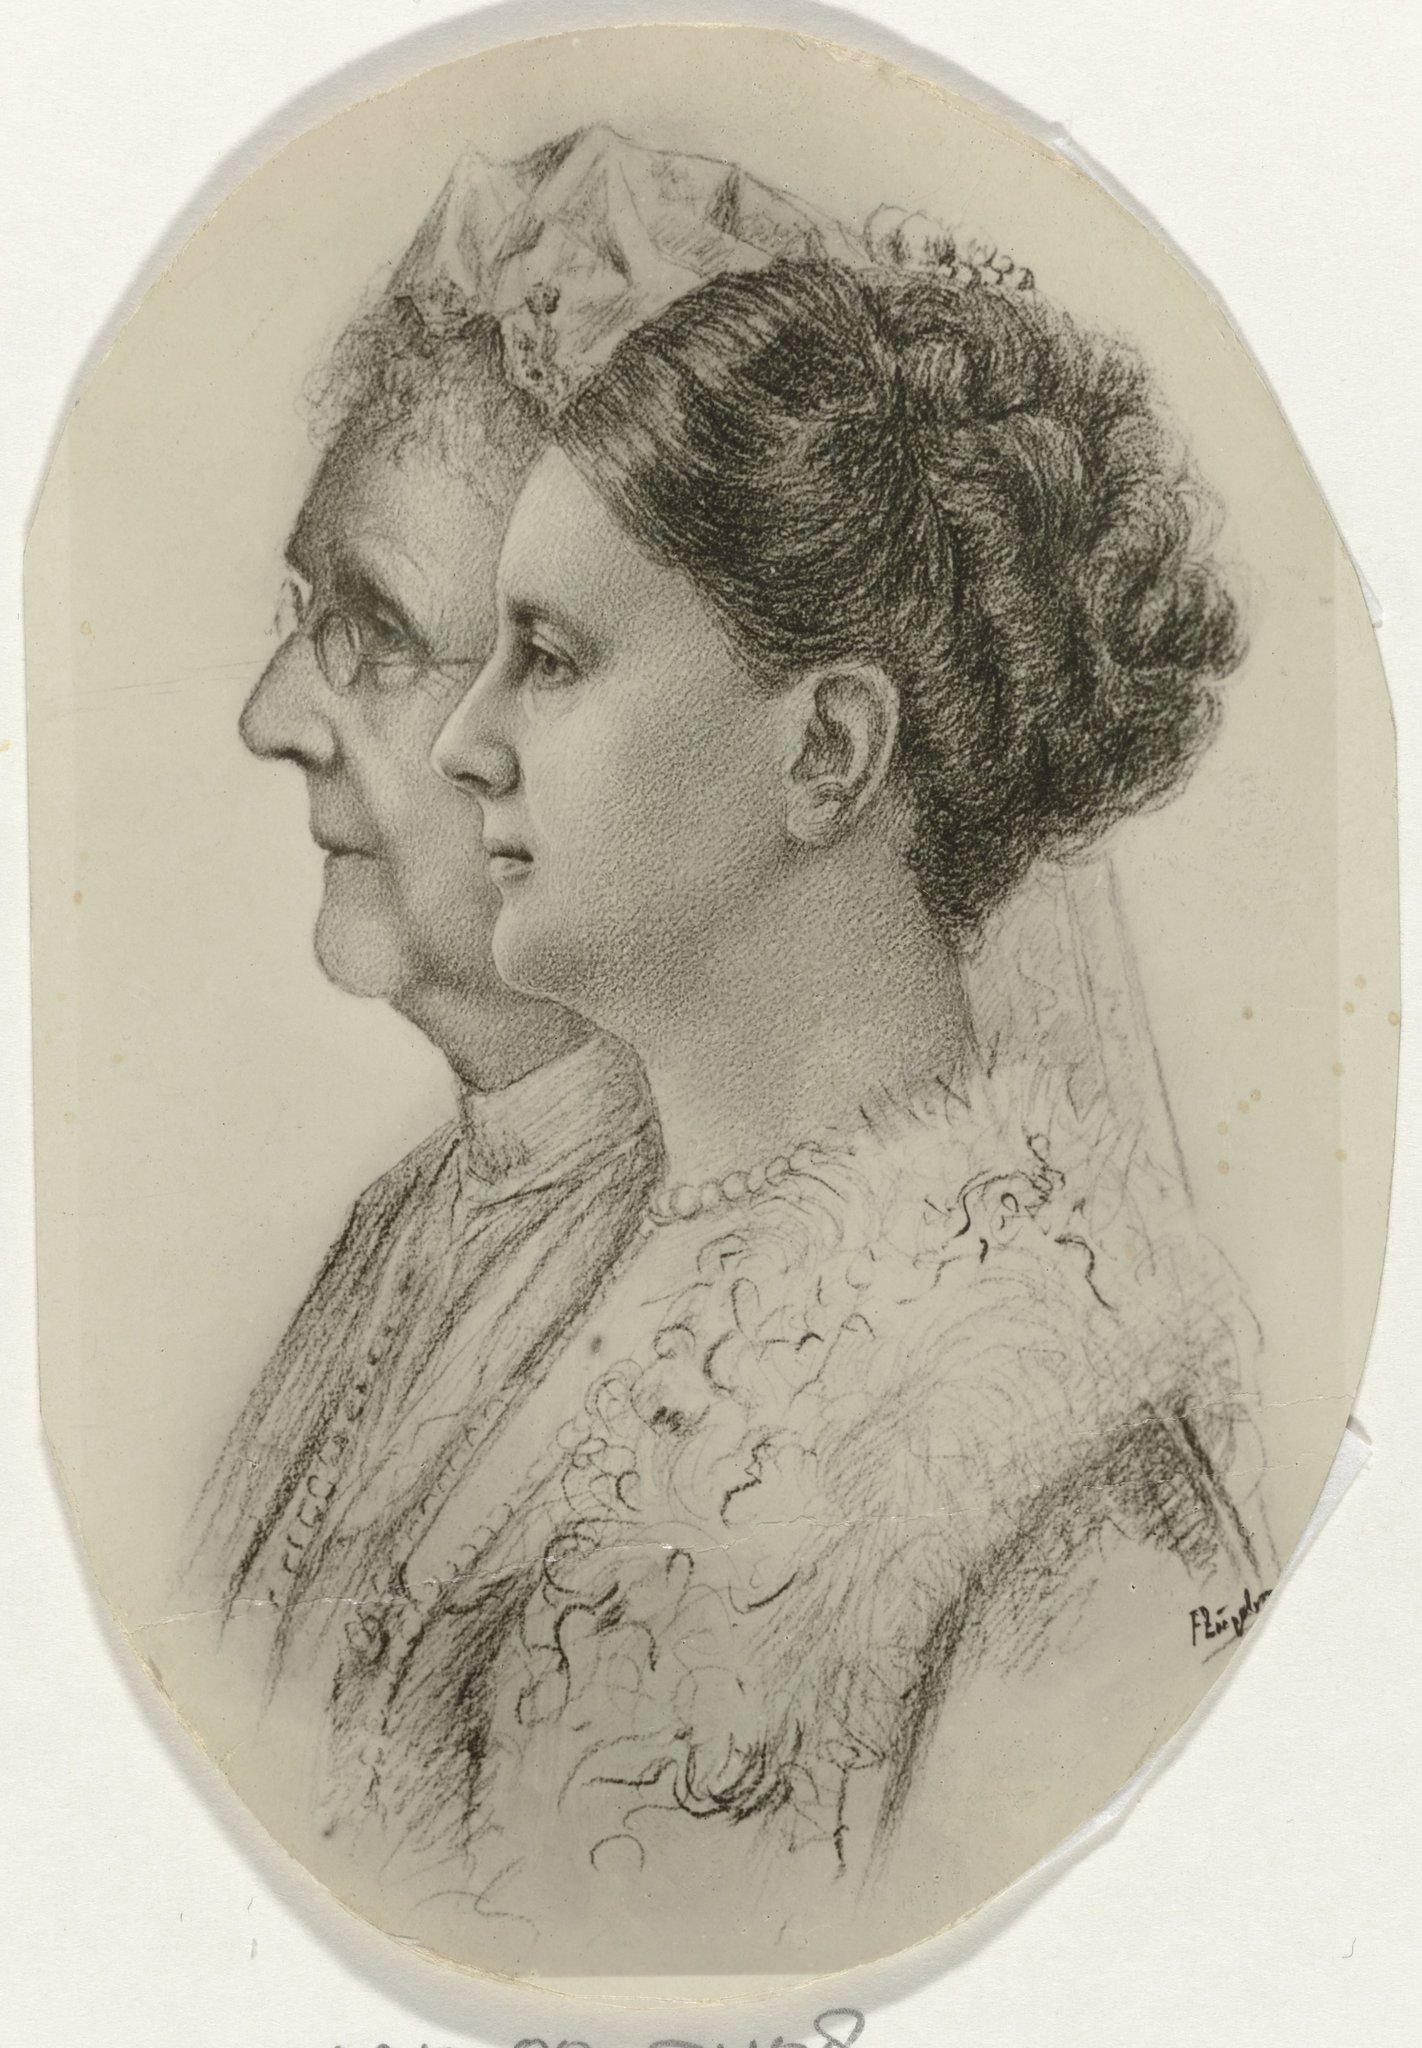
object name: photograph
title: Portret van Emma, koningin-regentes der Nederlanden, en Wilhelmina, koningin der Nederlanden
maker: franz ziegler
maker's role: fotograaf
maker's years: 1893-1939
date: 1928-1930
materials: photographic support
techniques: photography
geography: rijswijk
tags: wilhelmina of the netherlands, the hague, emma (queen consort of the netherlands)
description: De hier vermelde titel verwijst naar de hoogst verkregen titel van de geportretteerde, niet per se naar de titel die de geportretteerde op deze voorstelling draagt. Franz Ziegler plaatste een portret van Wilhelmina door Herman Deutmann uit 1912 voor zijn portret van Emma uit 1928.